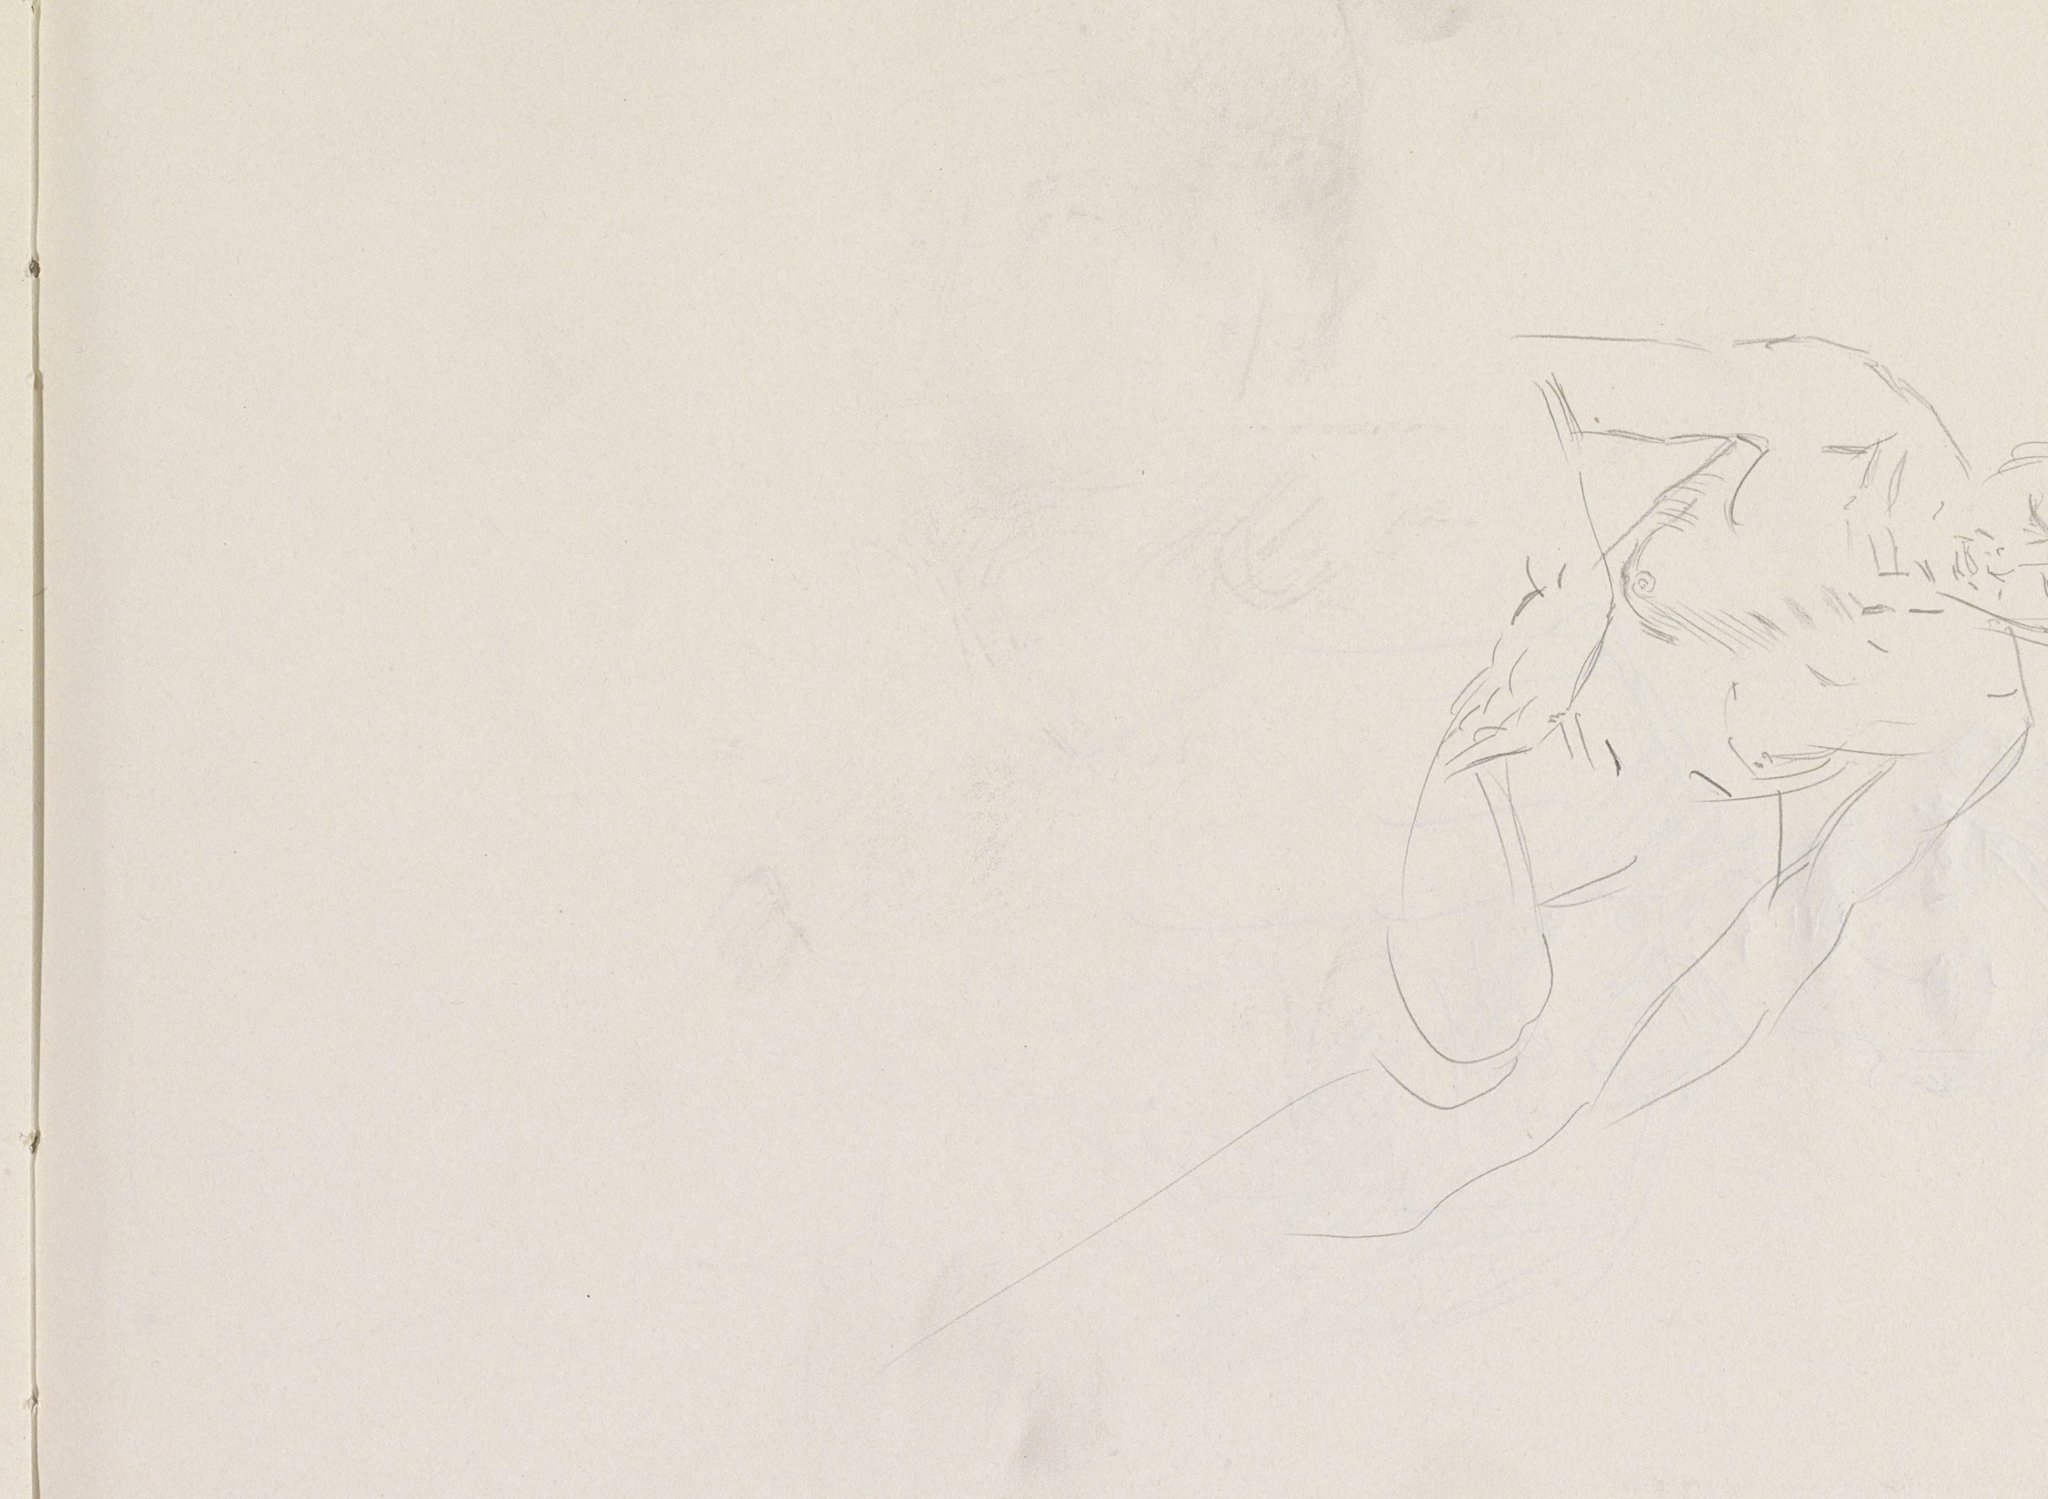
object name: sketchbook leaf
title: Seated Female Nude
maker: isaac israels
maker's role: draughtsman, painter, print maker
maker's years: 1865-1934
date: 1915-1934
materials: paper, pencil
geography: the hague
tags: sitting figure - aa - female human figure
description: Ze leunt op haar rechterarm. Blad 35 recto uit schetsboek III met 36 bladen.